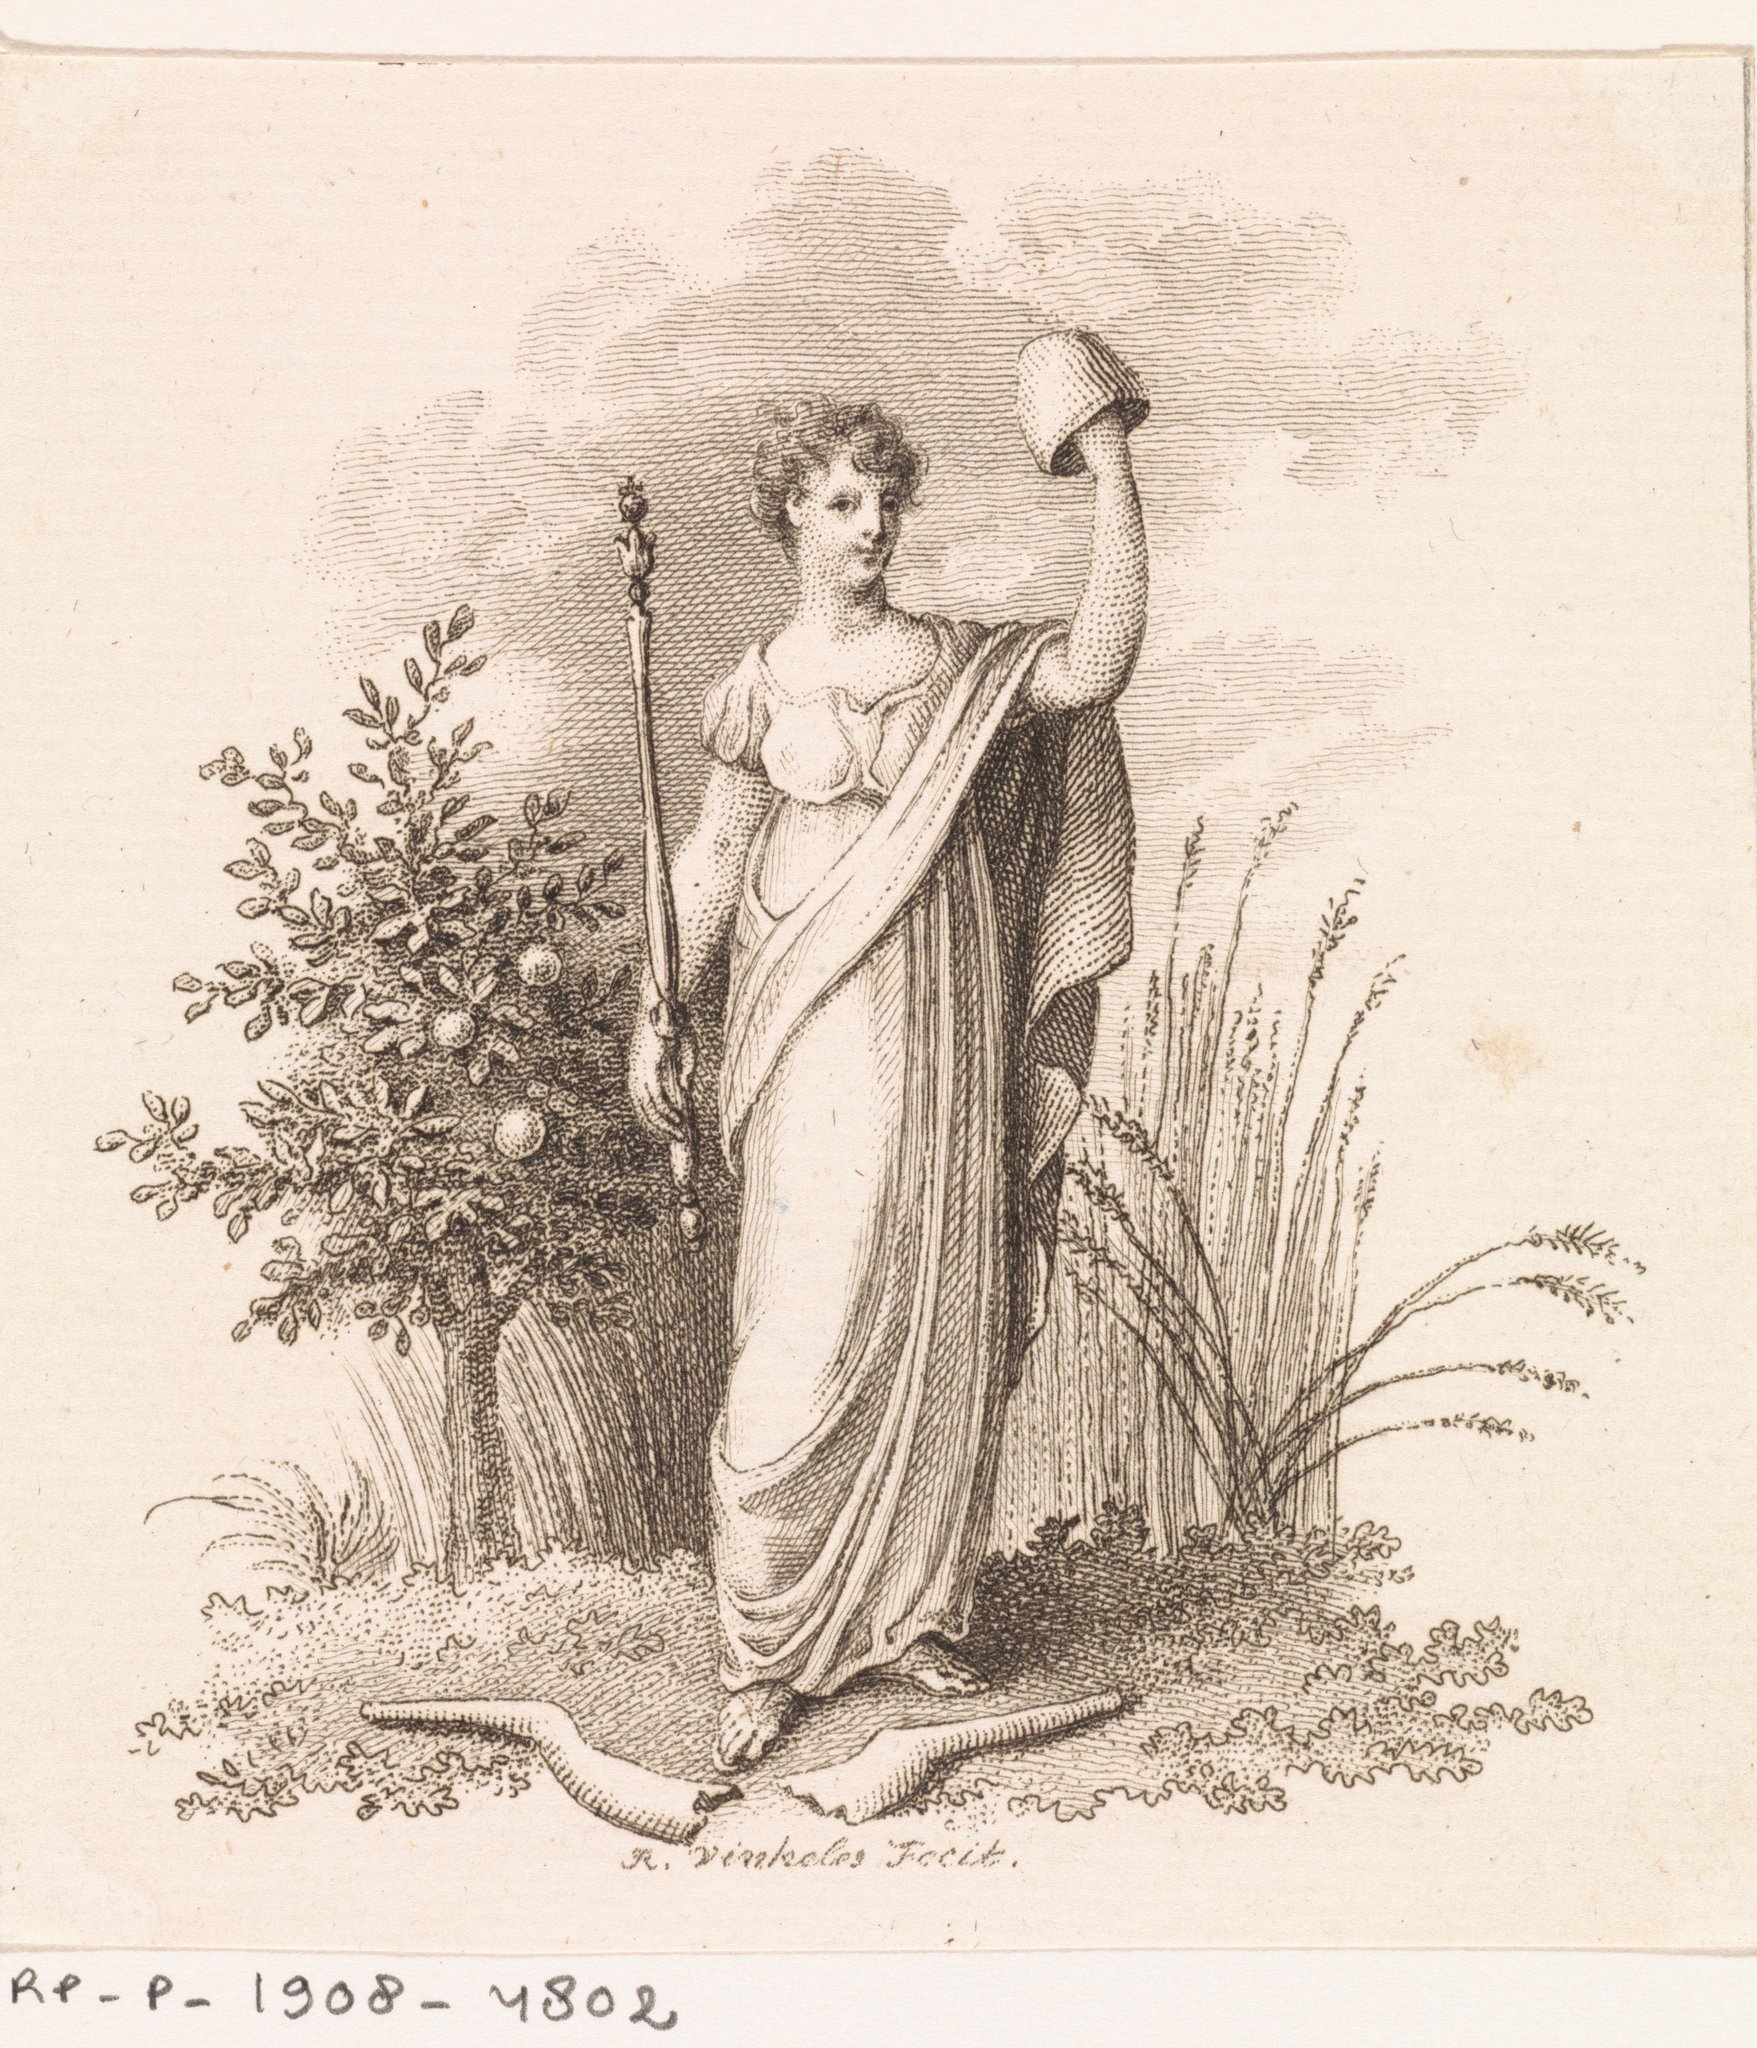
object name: print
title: Jonge vrouw met een hoed en een staf bij een fruitboom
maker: reinier vinkeles (i)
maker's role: draughtsman, print maker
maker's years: 1741-1816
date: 1751-1816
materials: paper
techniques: engraving, etching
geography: amsterdam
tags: fruit-tree culture; fruit harvest, head-gear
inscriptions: collector's mark: Lugt 2228